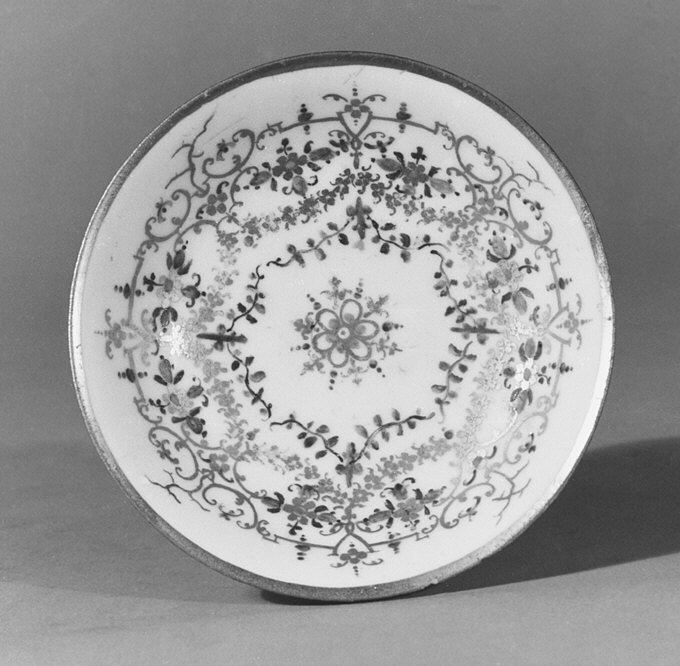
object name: saucer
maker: meissen manufactory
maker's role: manufactory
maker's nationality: german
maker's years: 1710-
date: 1715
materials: hard paste porcelain